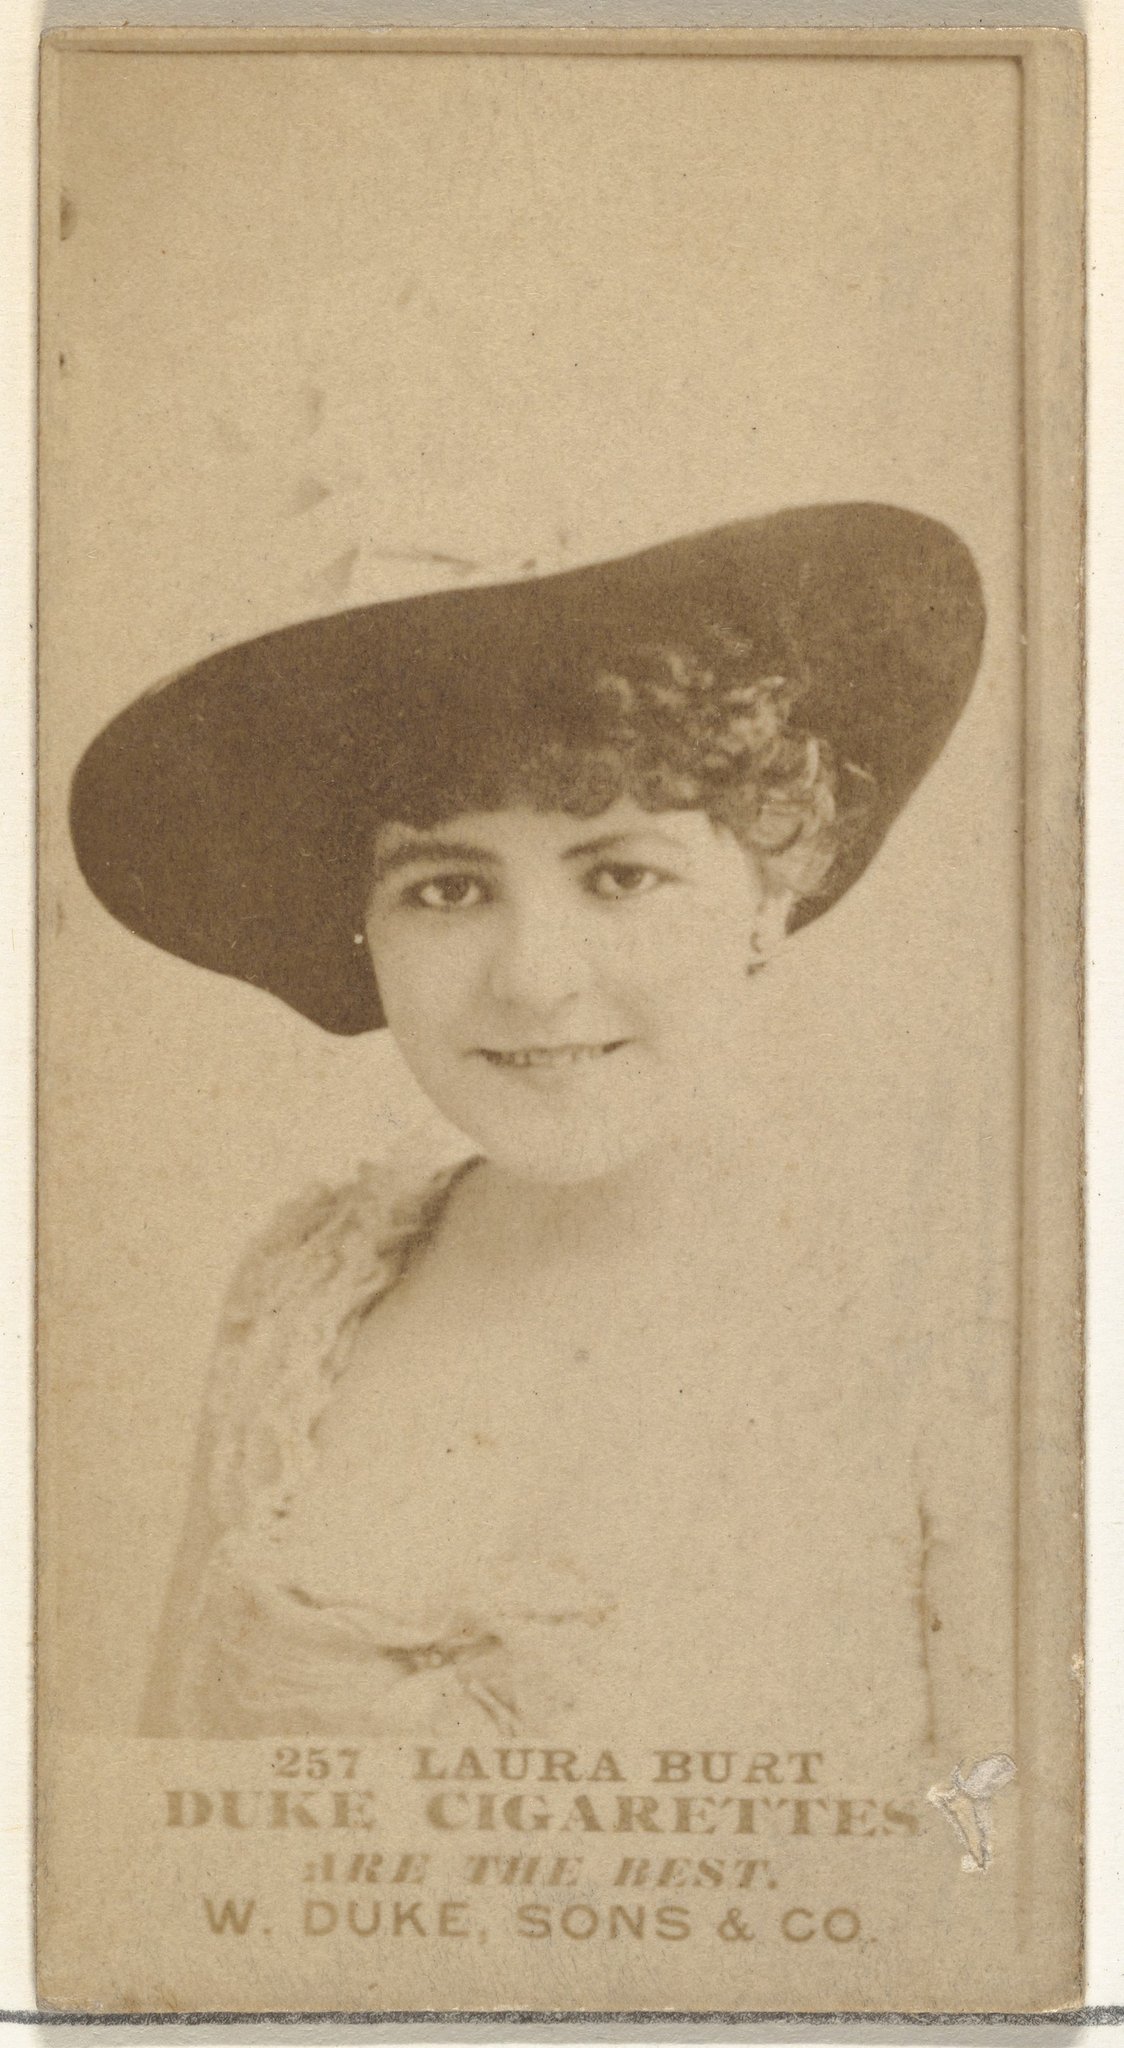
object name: photograph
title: Card Number 257, Laura Burt, from the Actors and Actresses series (N145-7) issued by Duke Sons & Co. to promote Duke Cigarettes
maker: w. duke, sons & co.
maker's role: publisher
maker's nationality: american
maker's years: 1870-1920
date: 1880-1889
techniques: albumen silver print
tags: portraits,women,actresses